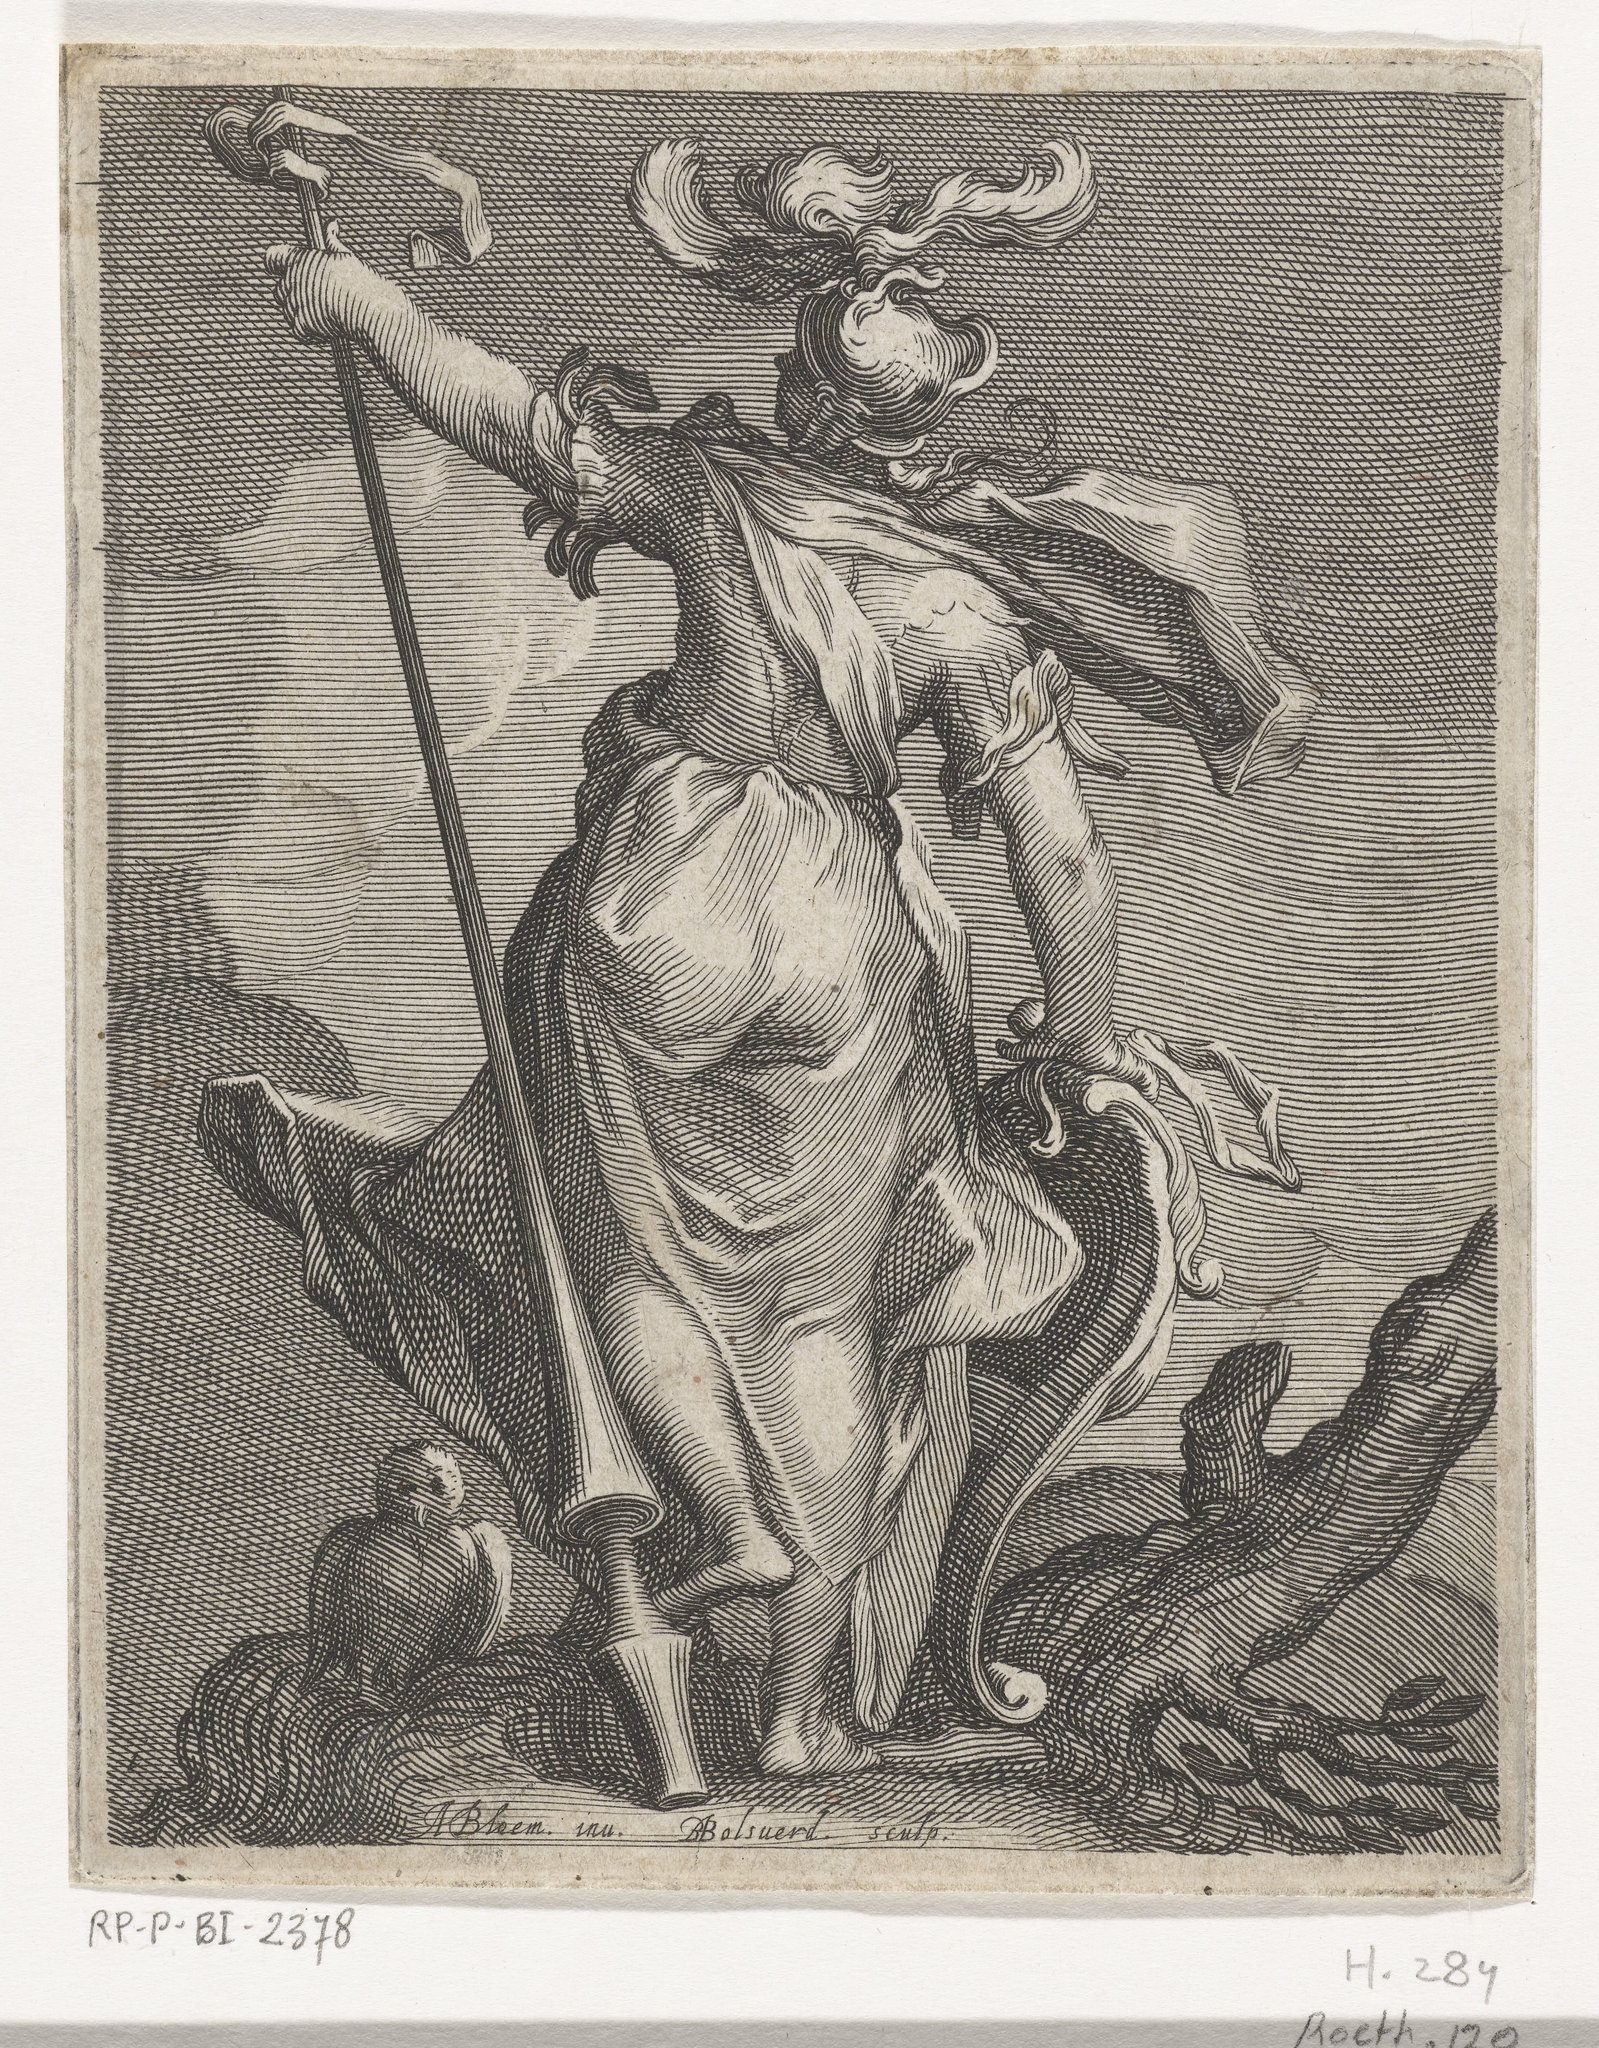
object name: print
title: Minerva met wapenrusting en uil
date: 1610-1614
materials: paper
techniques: engraving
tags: (story of) minerva (pallas, athena), attributes of minerva: owl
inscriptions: collector's mark: Lugt 240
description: Prent naar ontwerp van Abraham Bloemaert. Roethlisberger brengt deze prent in verband met een prent met venus en Cupido (vergelijk RP-P-BI-2376, Roethlisberger 1993, p. 158).